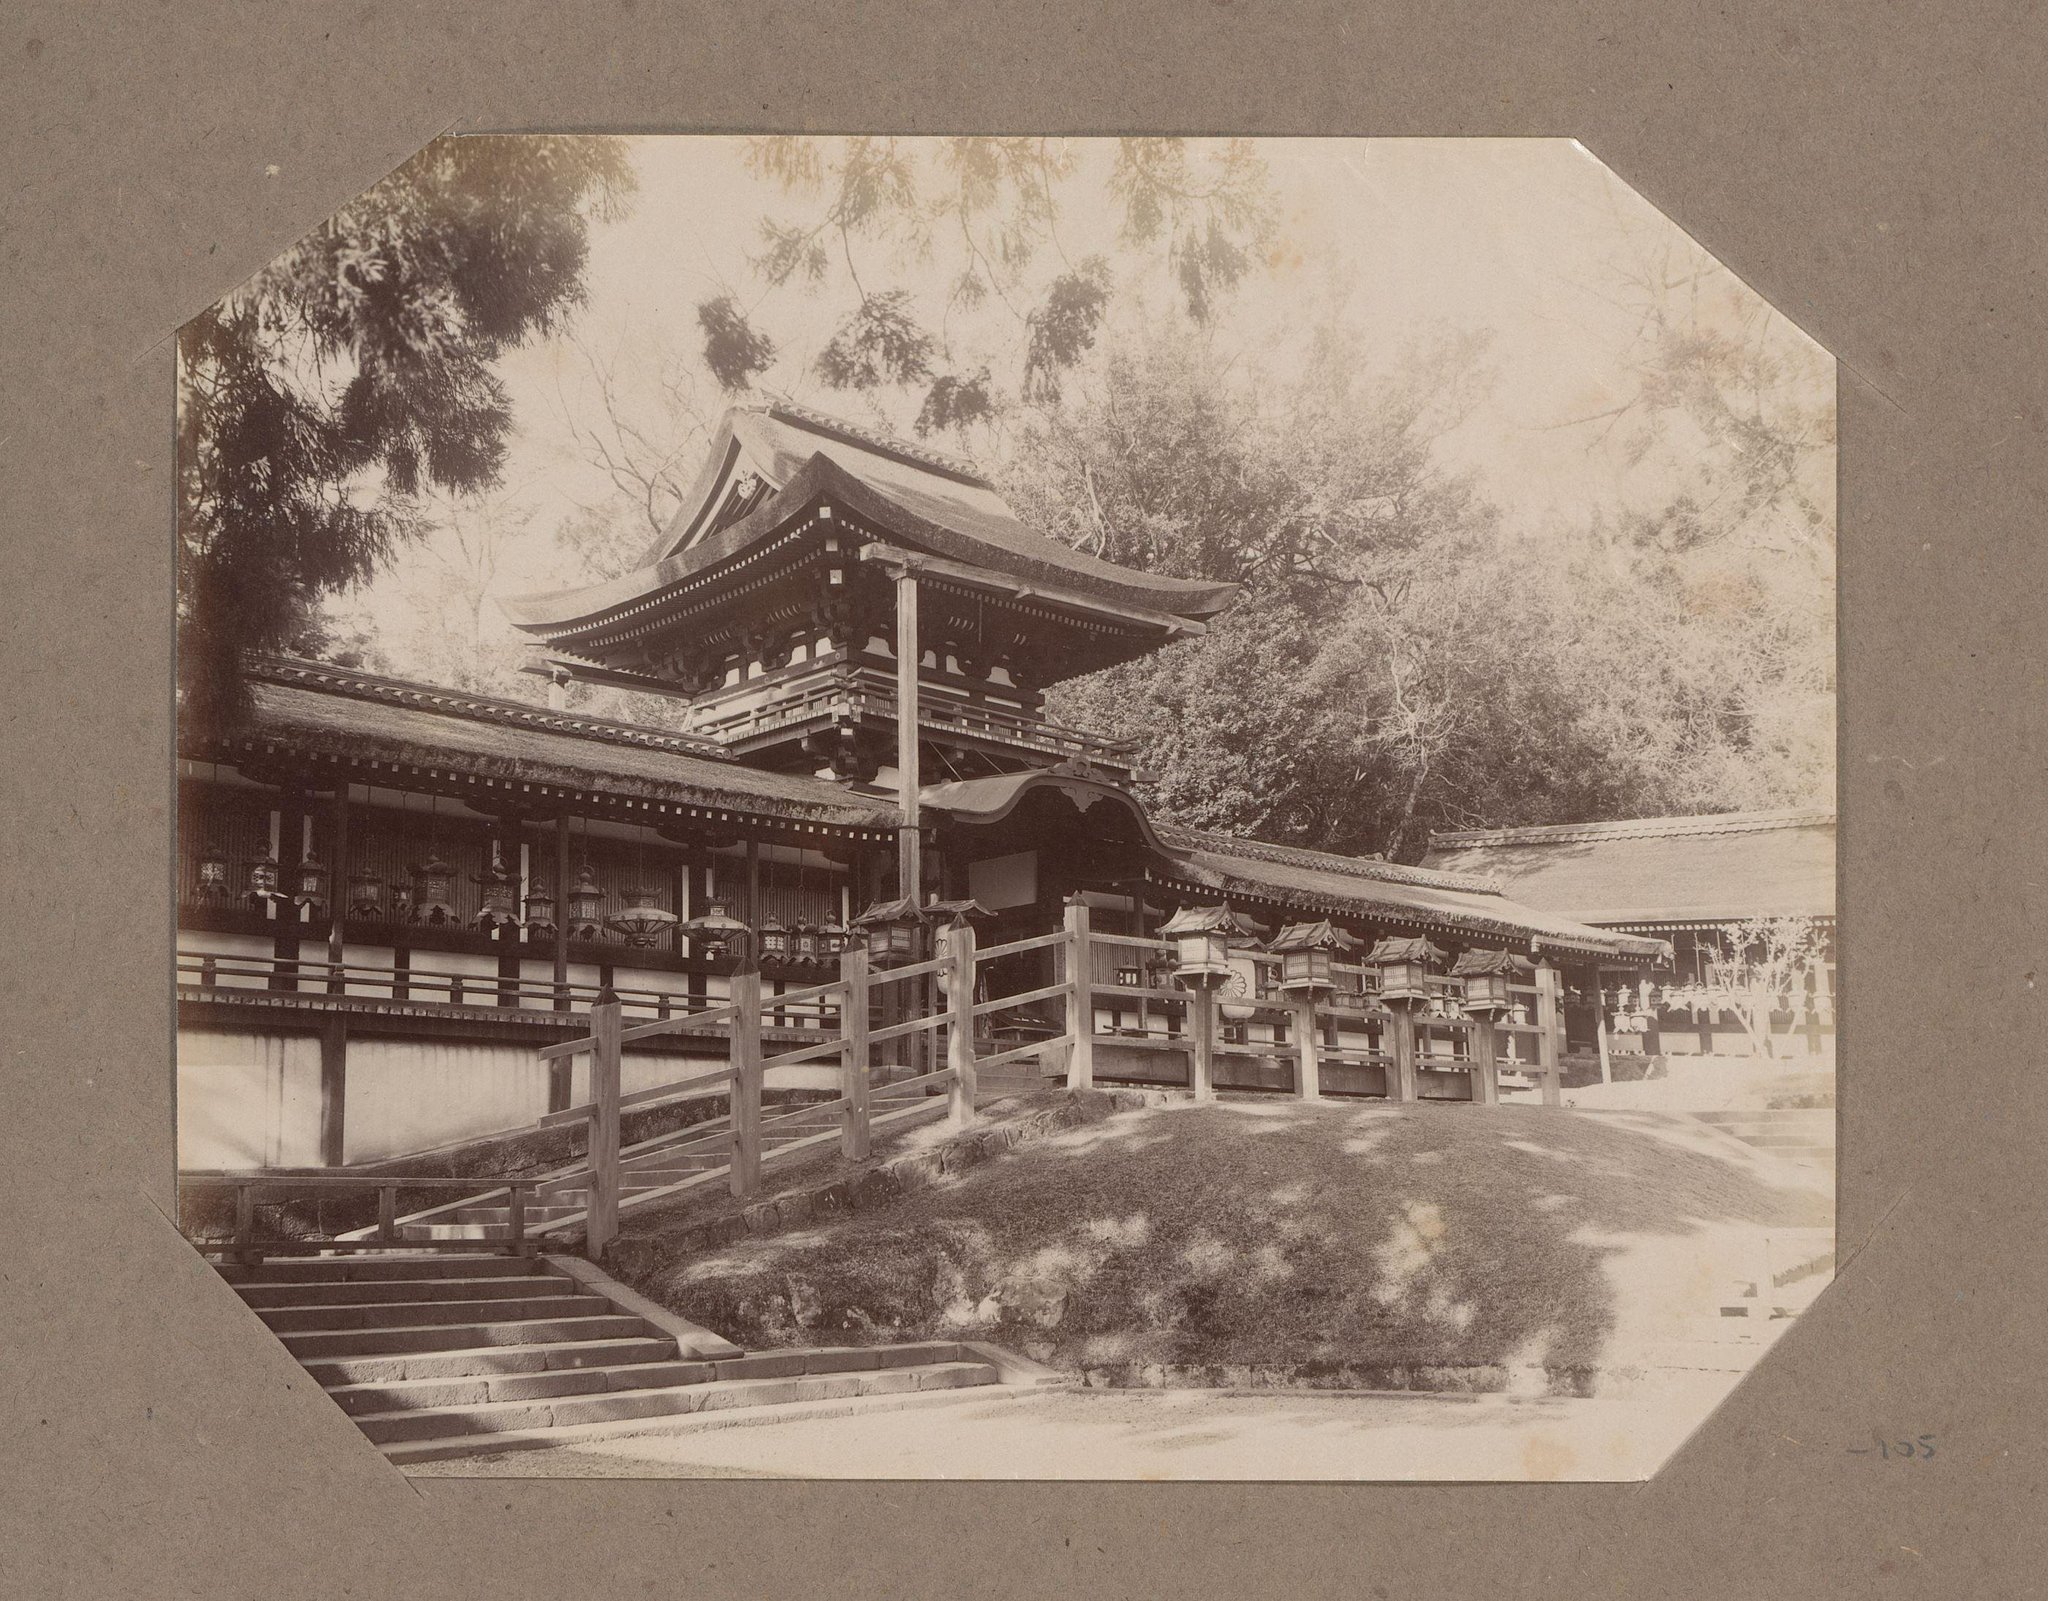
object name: photograph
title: Gezicht op een tempel, vermoedelijk in Nara, Japan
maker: Anonymous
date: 1890-1903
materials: paper, photographic support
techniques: albumen print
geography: nara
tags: temple, shrine ~ shinto, japan